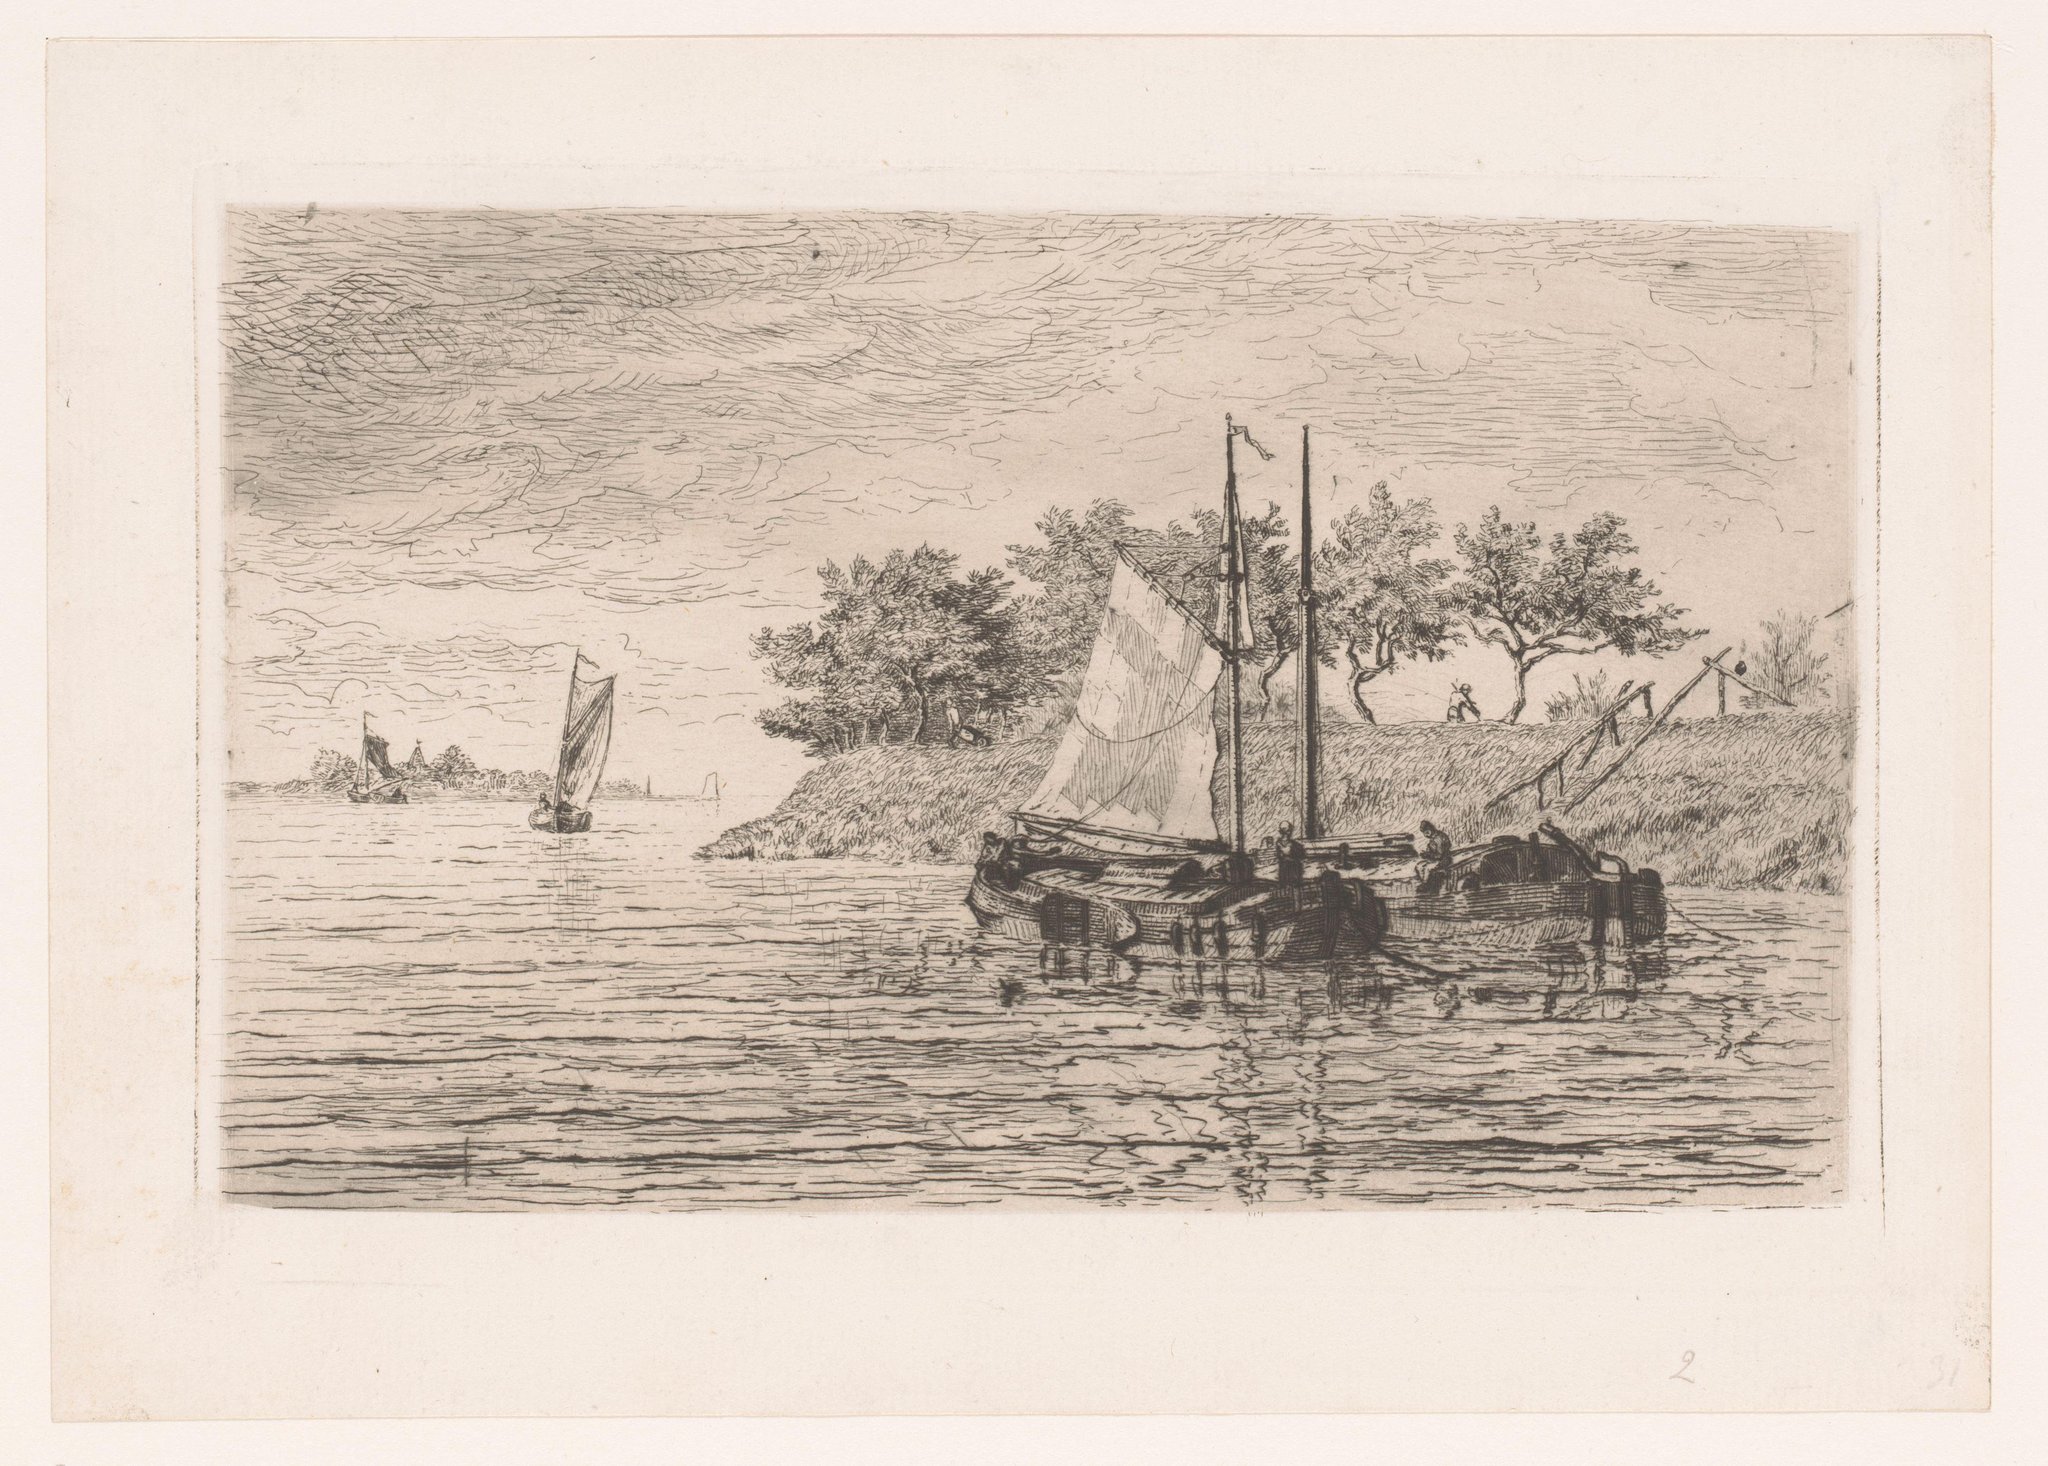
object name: print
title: Zeilboten op een rivier, op de dijk staat een man te maaien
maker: edgar alfred baes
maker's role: print maker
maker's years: 1837-1909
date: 1847-1909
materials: paper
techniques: drypoint, etching, intaglio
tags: sailing-ship, sailing-boat, river, river bank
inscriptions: collector's mark: Lugt 2228